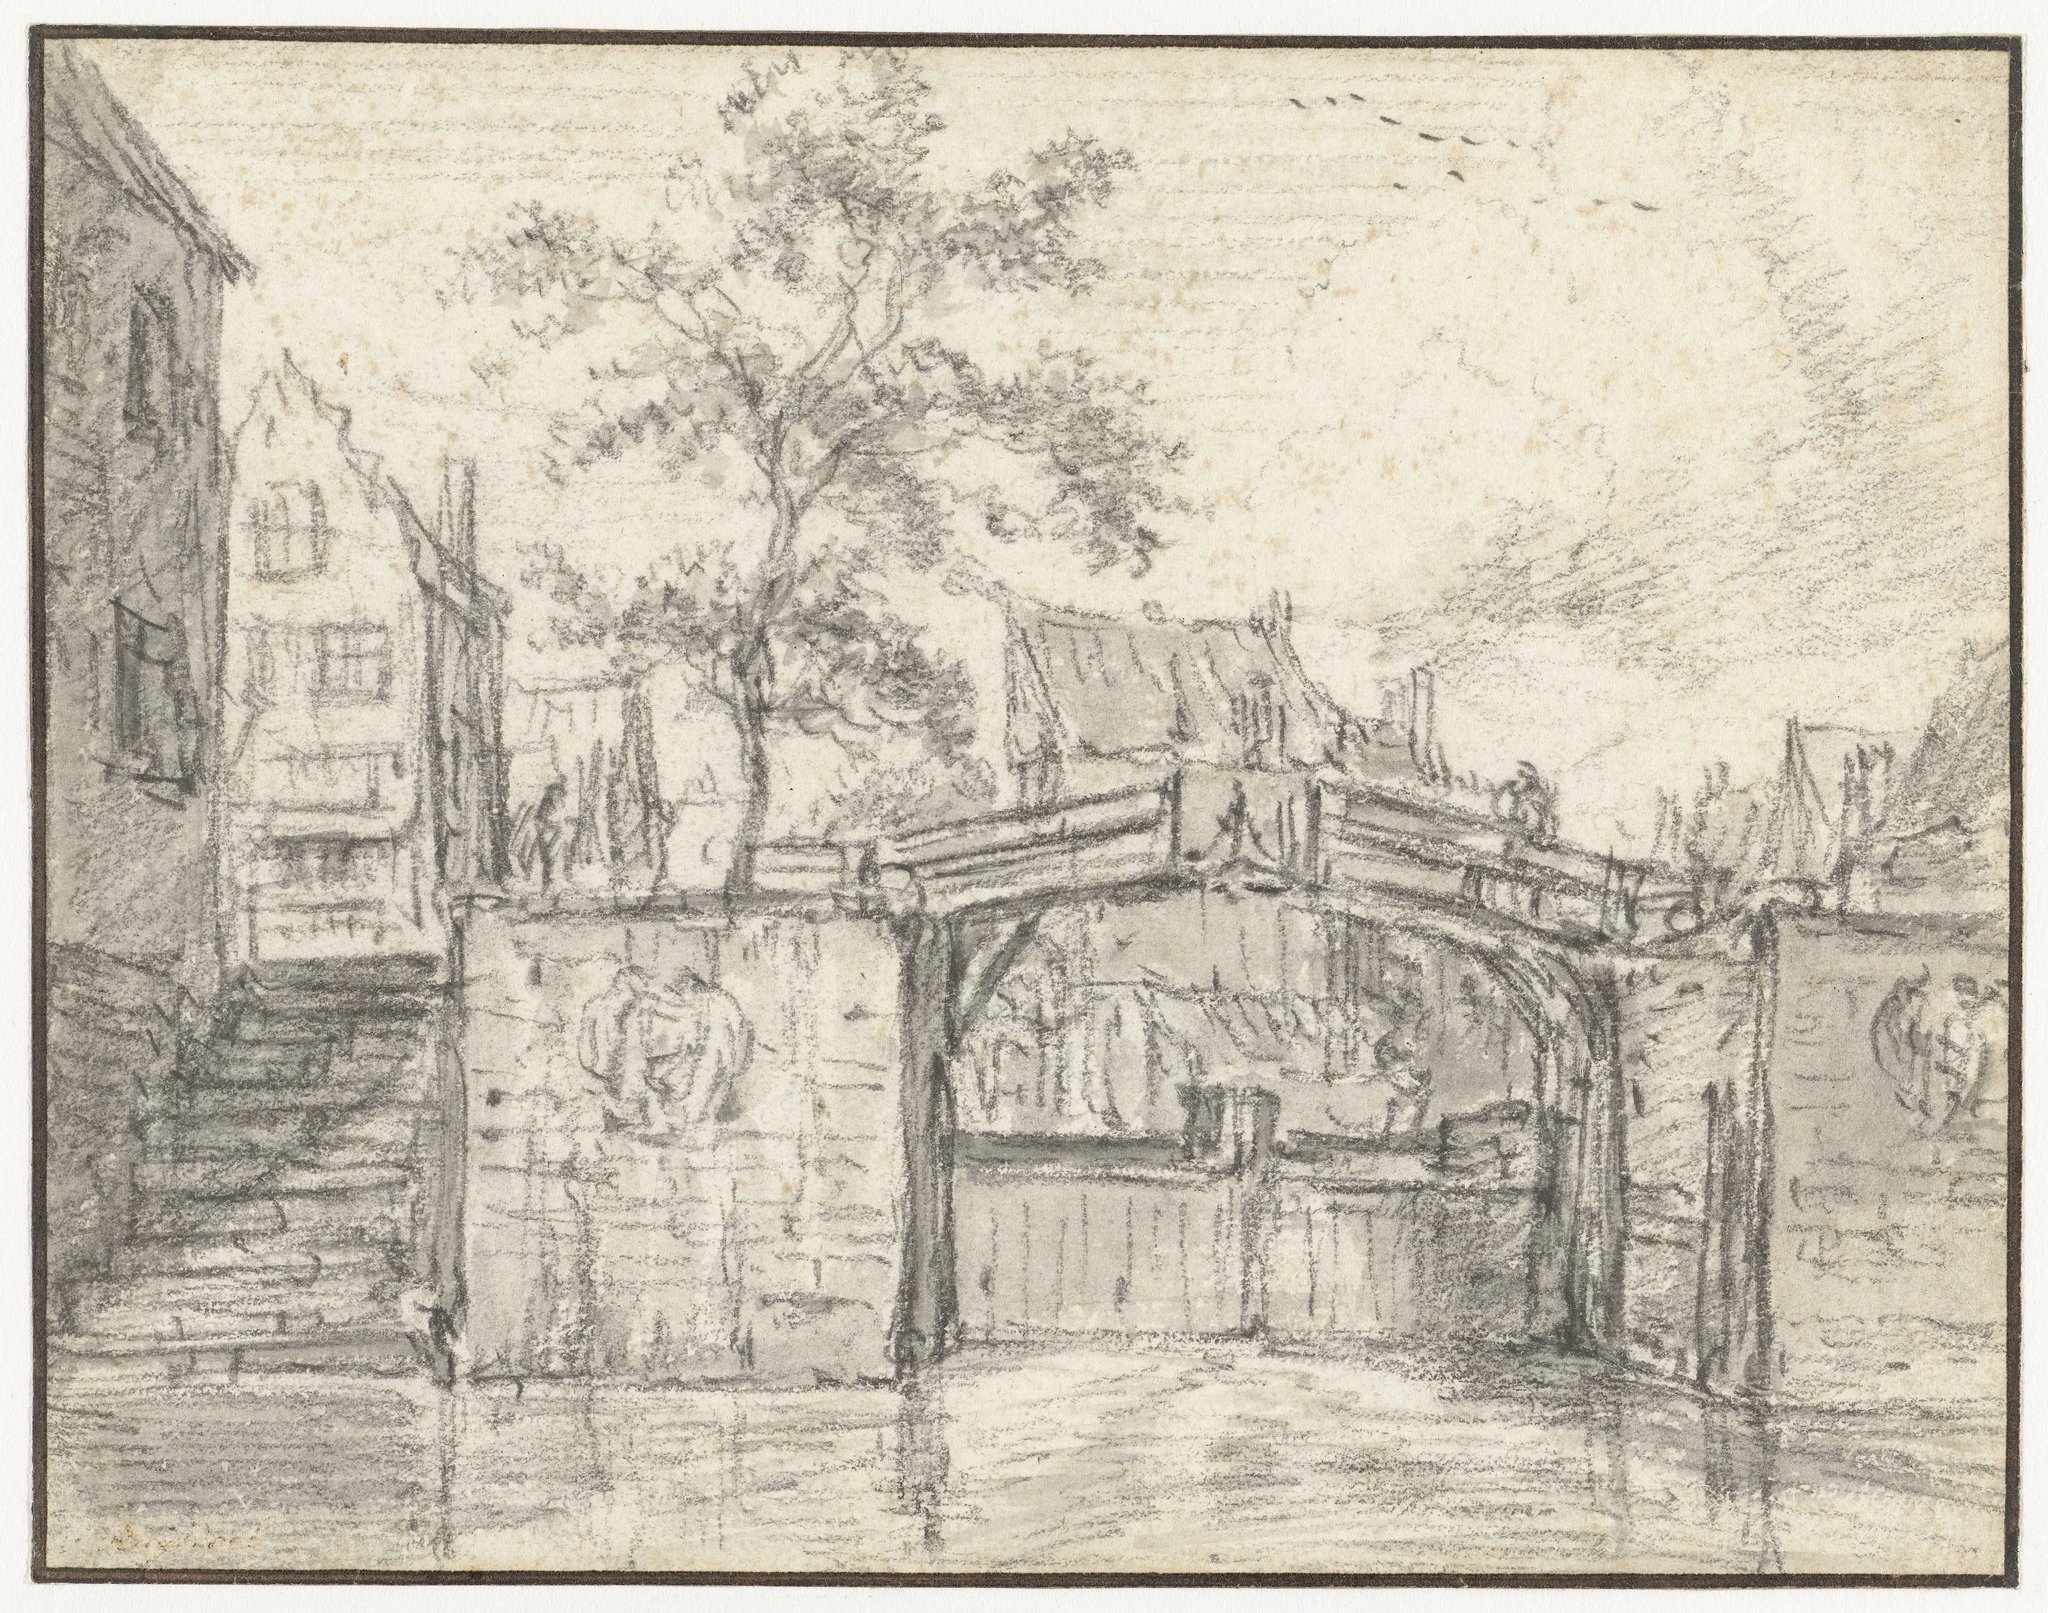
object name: drawing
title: The Oude Haarlemmersluis (Old Haarlem Lock) on the Martelaarsgracht, Amsterdam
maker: jacob isaacksz van ruisdael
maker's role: draughtsman, painter, print maker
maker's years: 1628-1682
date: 1638-1655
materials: chalk, ink, paper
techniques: brush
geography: amsterdam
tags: sluice, weir, canals, waters (in city), amsterdam